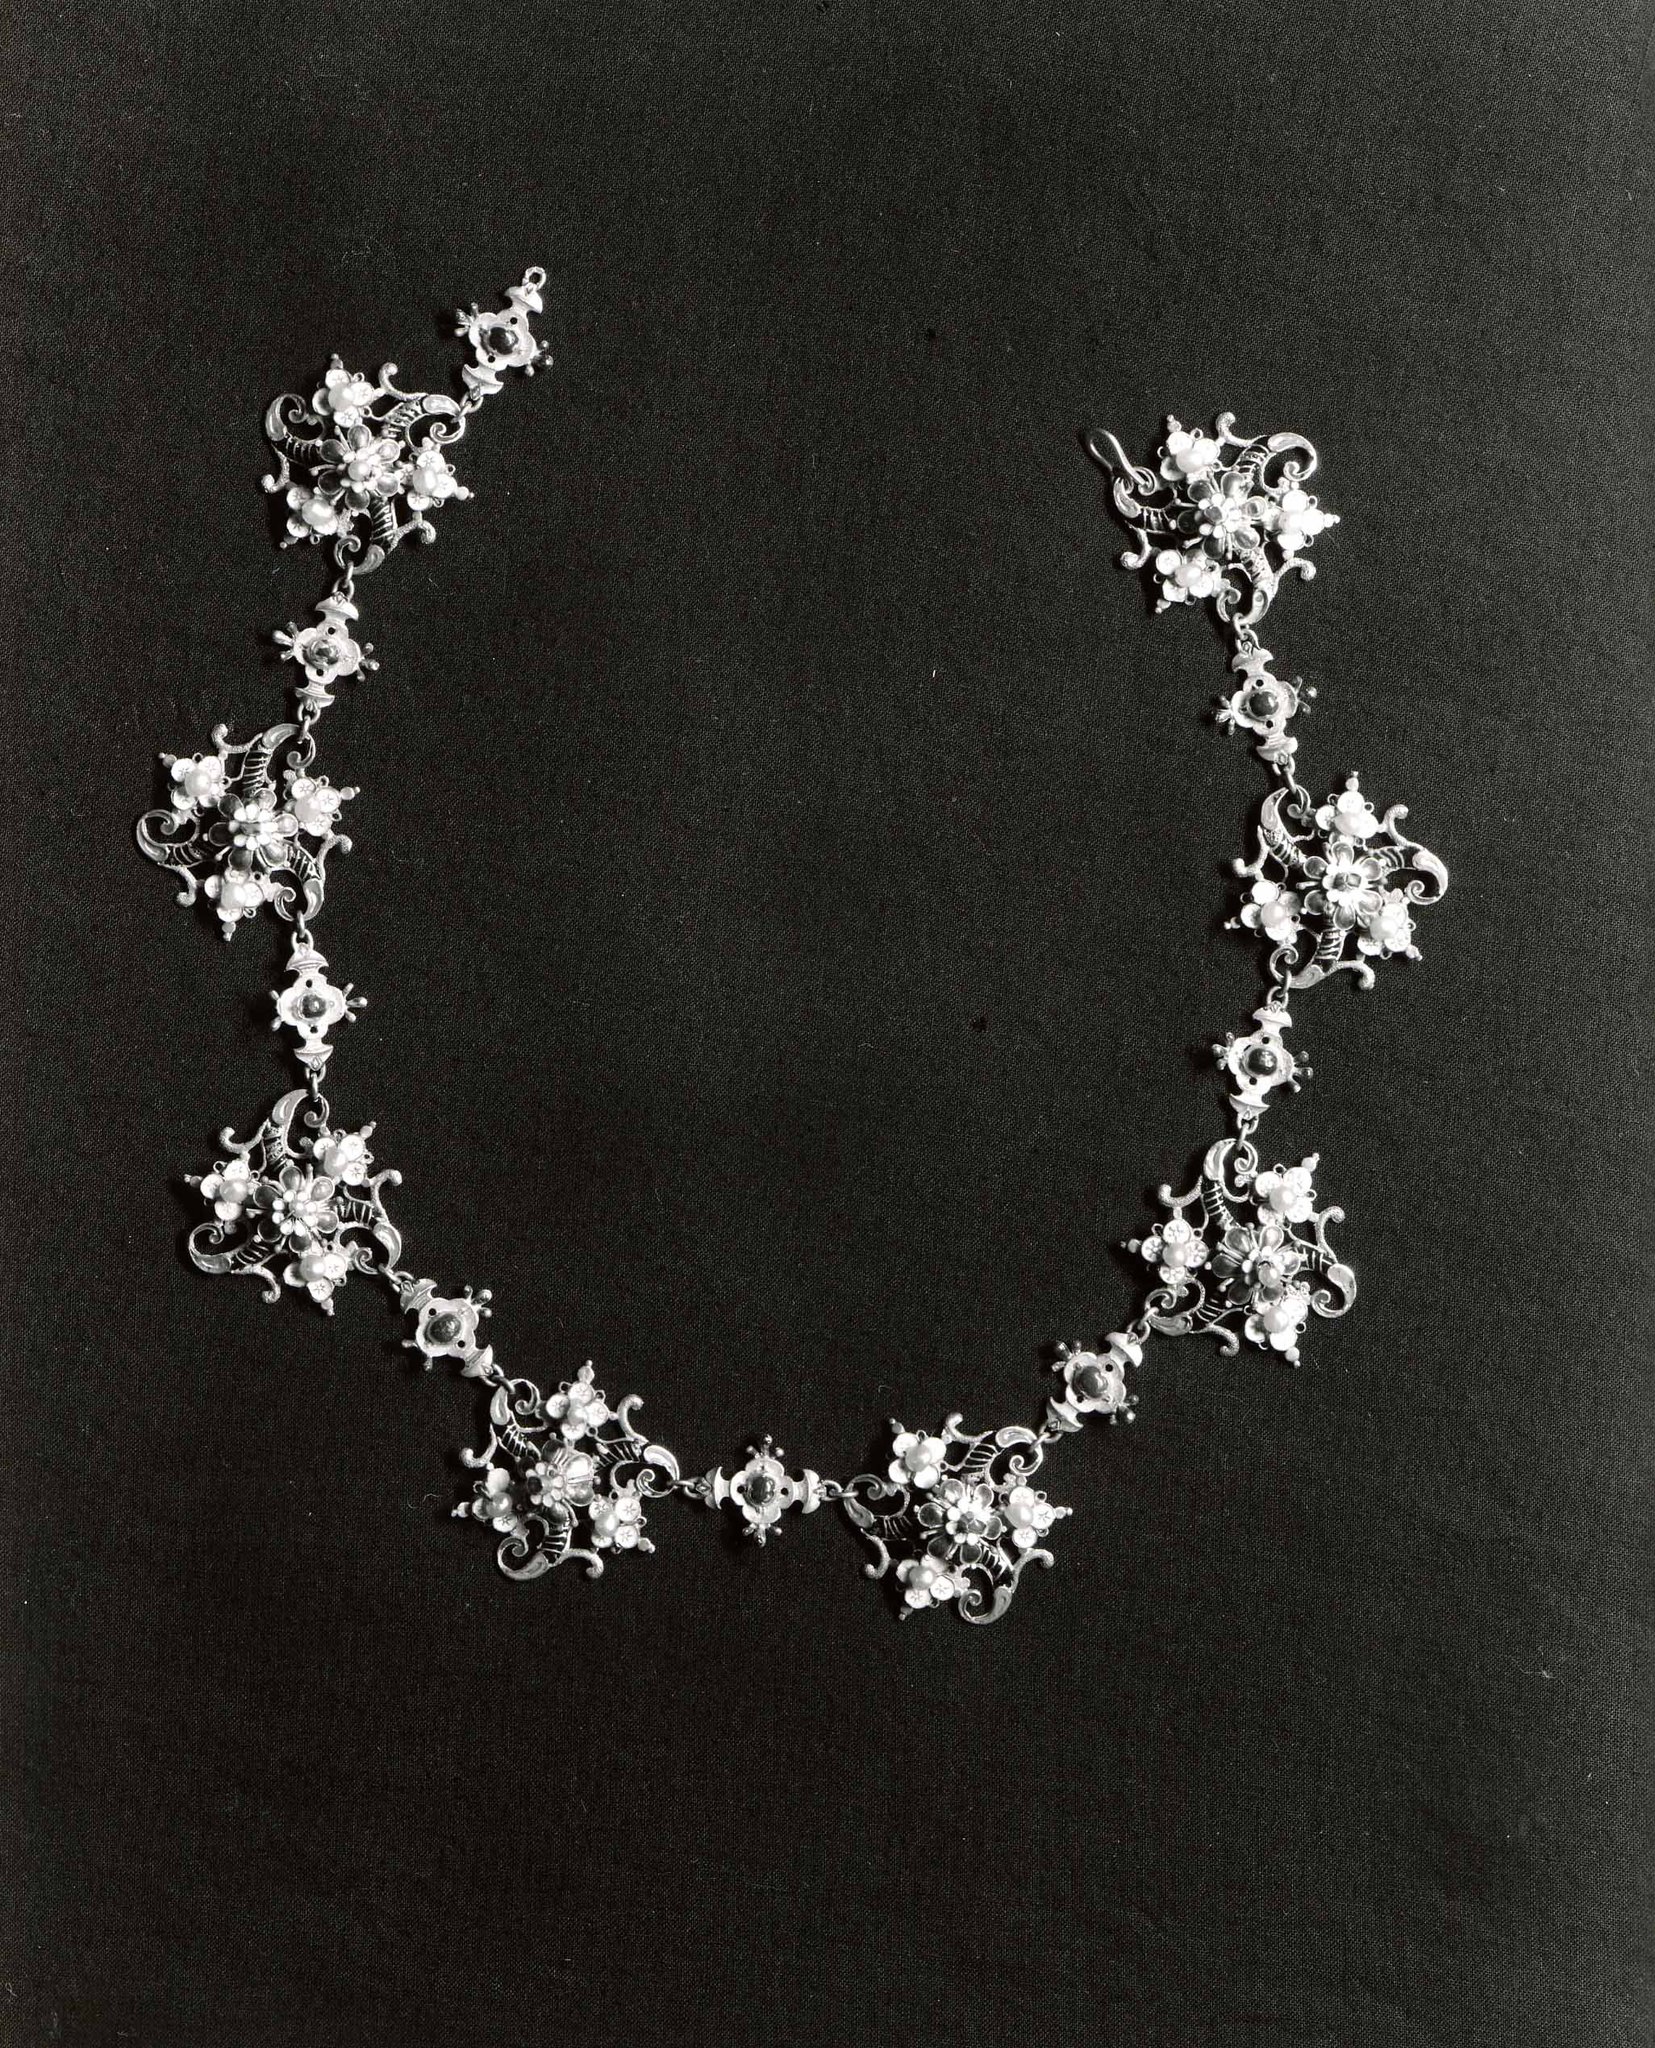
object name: necklace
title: Necklance Formed of Eight Dress Ornaments with Eight Links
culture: transylvanian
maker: transylvania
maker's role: artist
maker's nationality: transylvania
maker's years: 1600-1893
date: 1600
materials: enamel, gold, pearl, gemstone